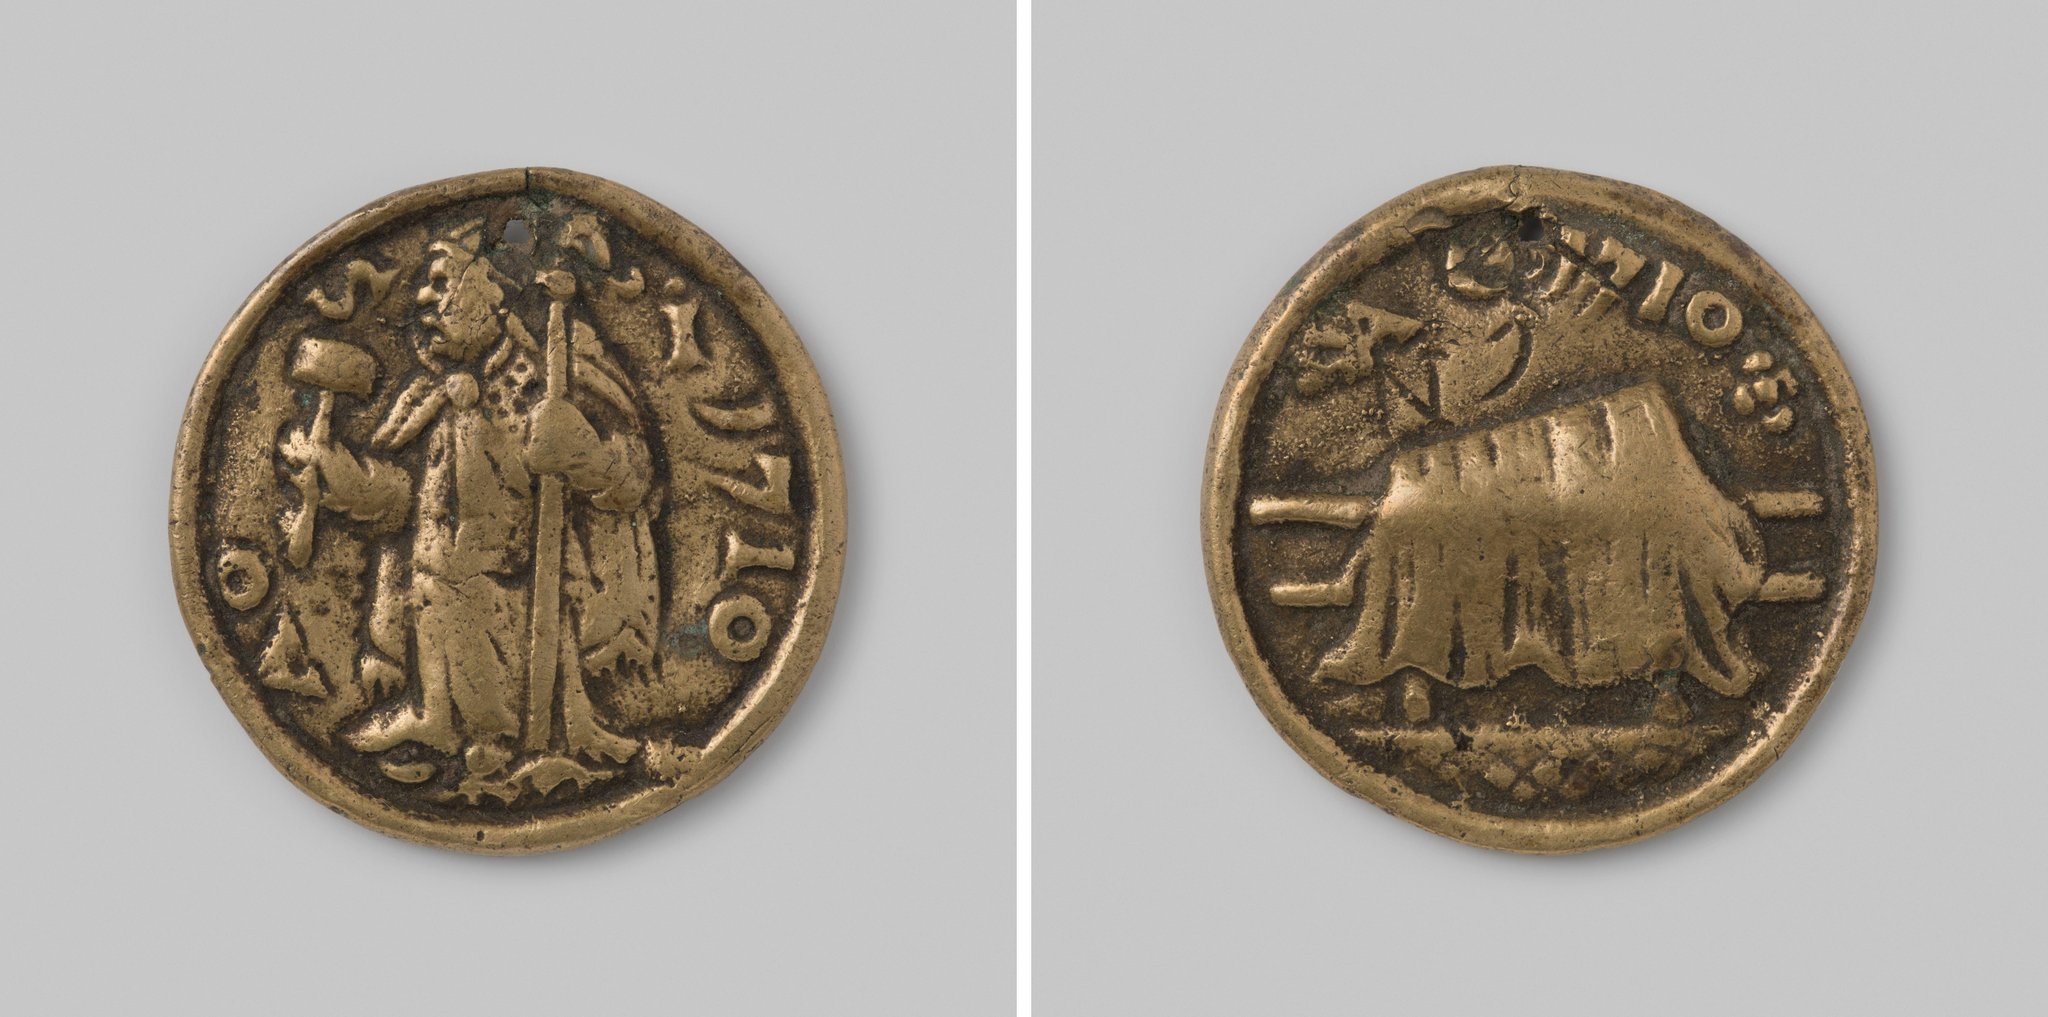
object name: medal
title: Begrafenispenning van het Sint Joseph- of steenhouwersgilde te 's-Gravenhage 1710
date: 1710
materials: brass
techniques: casting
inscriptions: circumscription: ‘Ao - 1710’, inscription: ‘N 1’, circumscription: ‘(roos) Ao 1710 (roos)’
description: Gegoten messing penning, op de voorzijde Sint Joseph met steenhouwershamer tussen S en I en het jaartal, op de keerzijde een lijkbaar waarboven het jaartal en incuus nummer 1, met draaggat